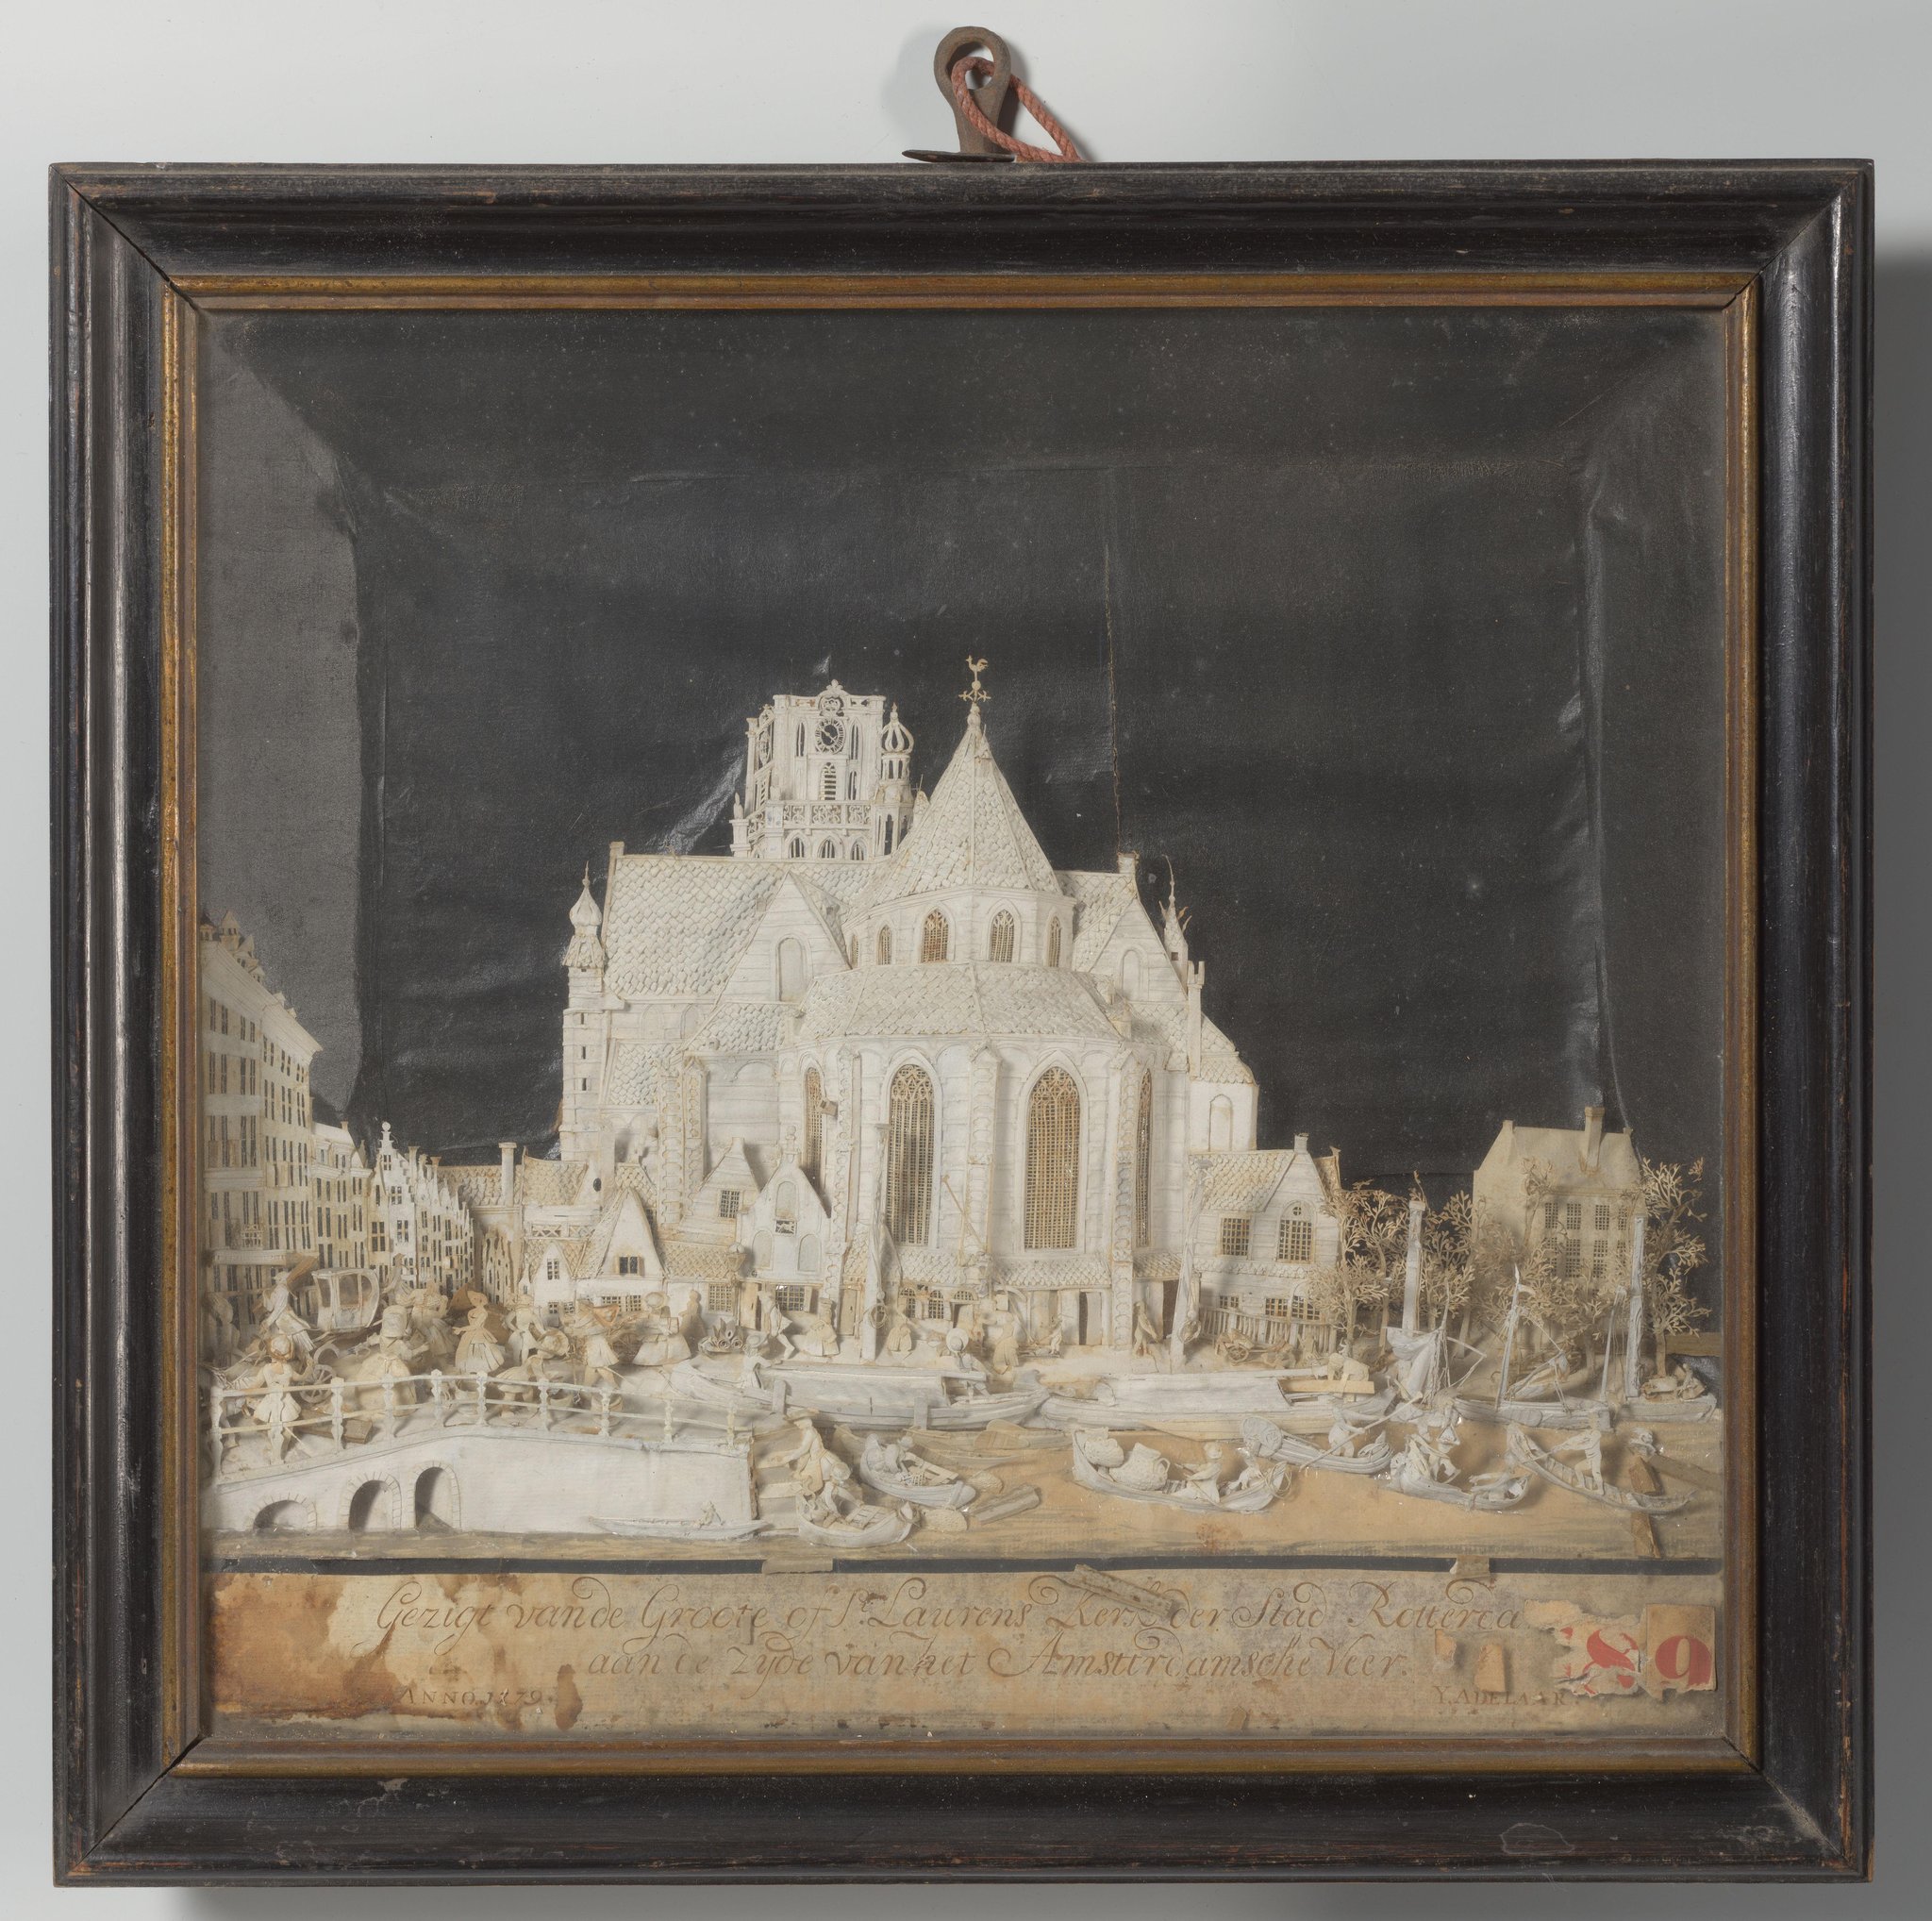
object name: cut paper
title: Gezicht op de Grote of St. Laurenskerk in Rotterdam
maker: jan adelaar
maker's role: matroos, papierknipper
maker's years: 1725-1811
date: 1779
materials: paper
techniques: snipping, wash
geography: rotterdam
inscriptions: date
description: Gezicht op de Grote of St. Laurenskerk in Rotterdam, gezien vanaf het Amsterdamse Veer. Vissers en kooplui zijn druk in de weer in de voorgrond.